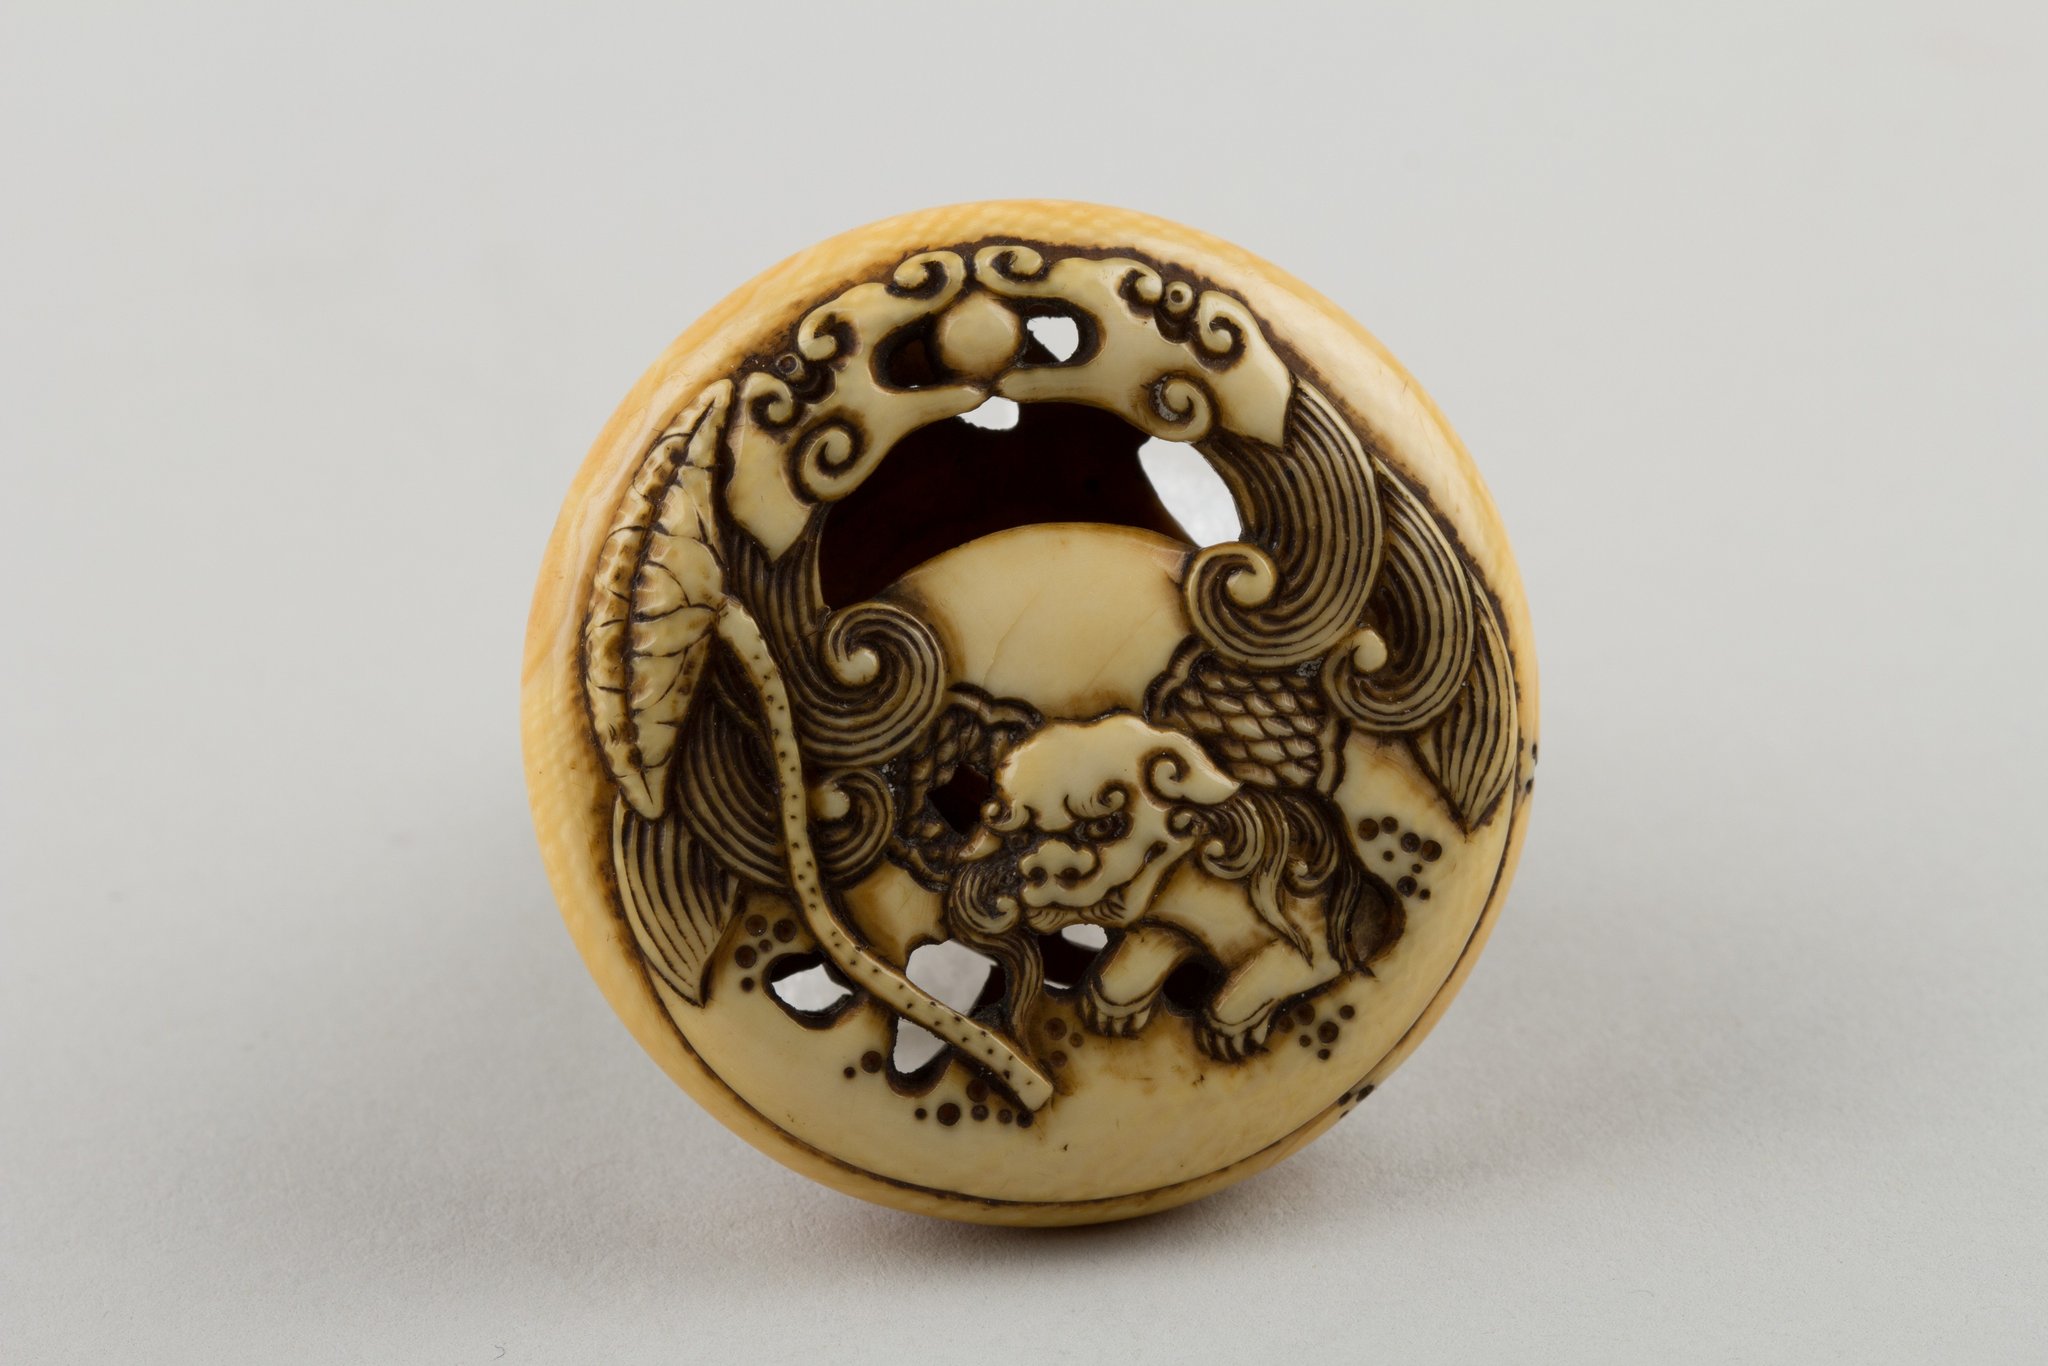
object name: netsuke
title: Netsuke Carved with Shishi; reverse with Lotus Leaf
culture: japanese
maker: rensai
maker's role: artist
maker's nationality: japanese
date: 1615-1868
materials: ivory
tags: lions